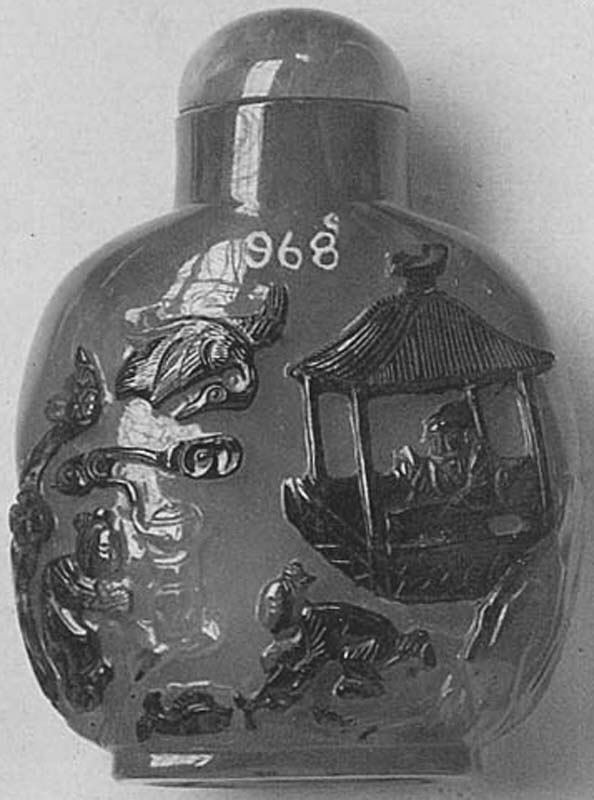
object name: snuff bottle with stopper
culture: chinese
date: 1701-1900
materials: stone, crystal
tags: human figures,birds